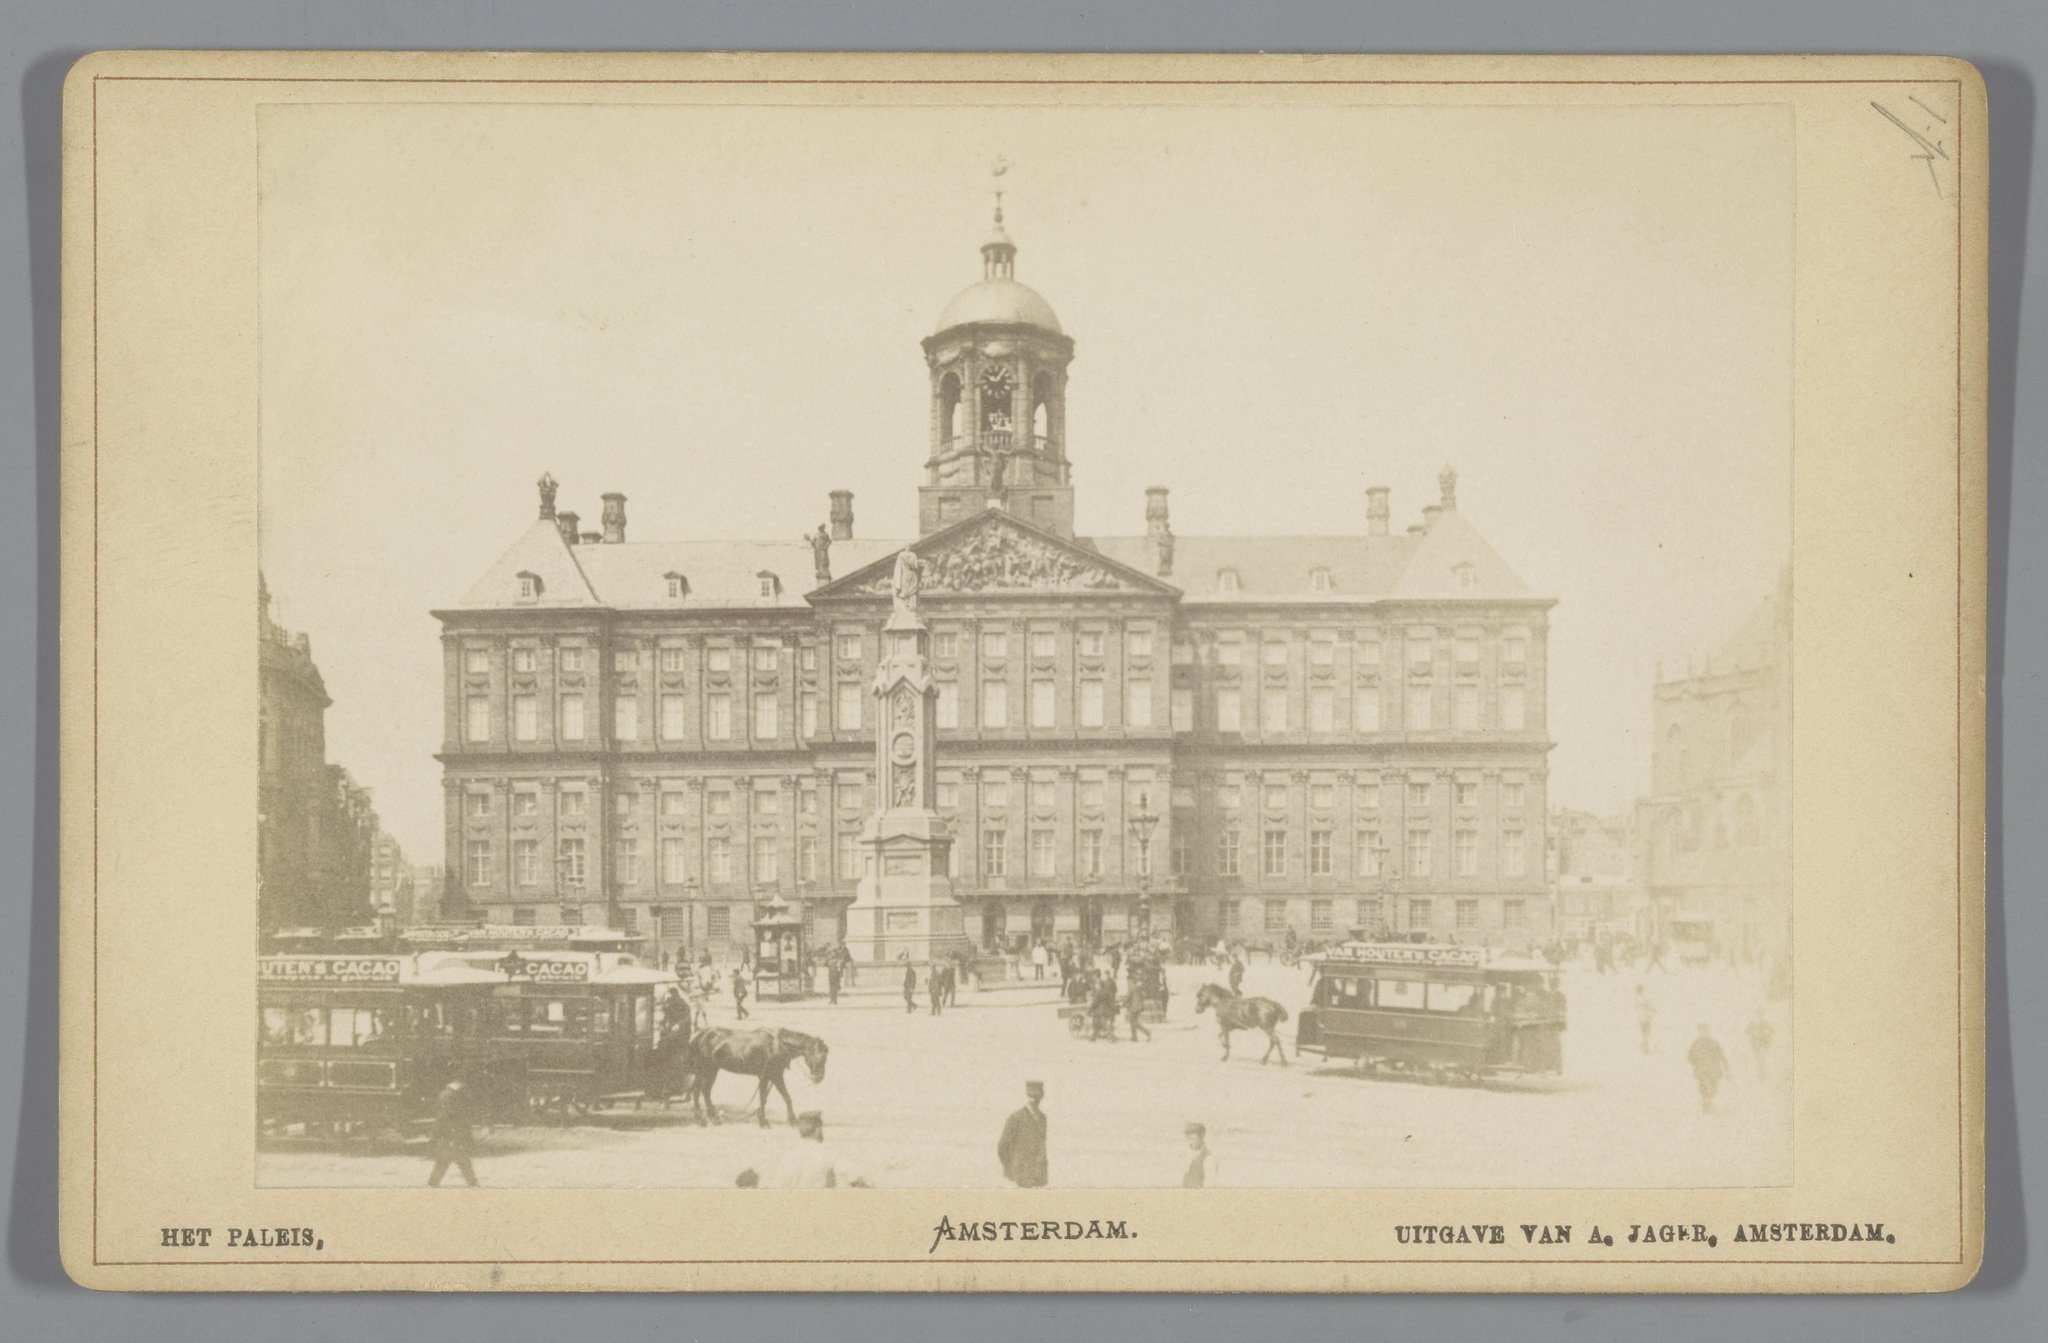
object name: cabinet photograph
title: Amsterdam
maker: andries jager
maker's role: publisher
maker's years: 1825-1905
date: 1860-1890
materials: cardboard, photographic support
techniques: albumen print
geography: amsterdam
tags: square, place, circus, etc., palace, royal palace of amsterdam